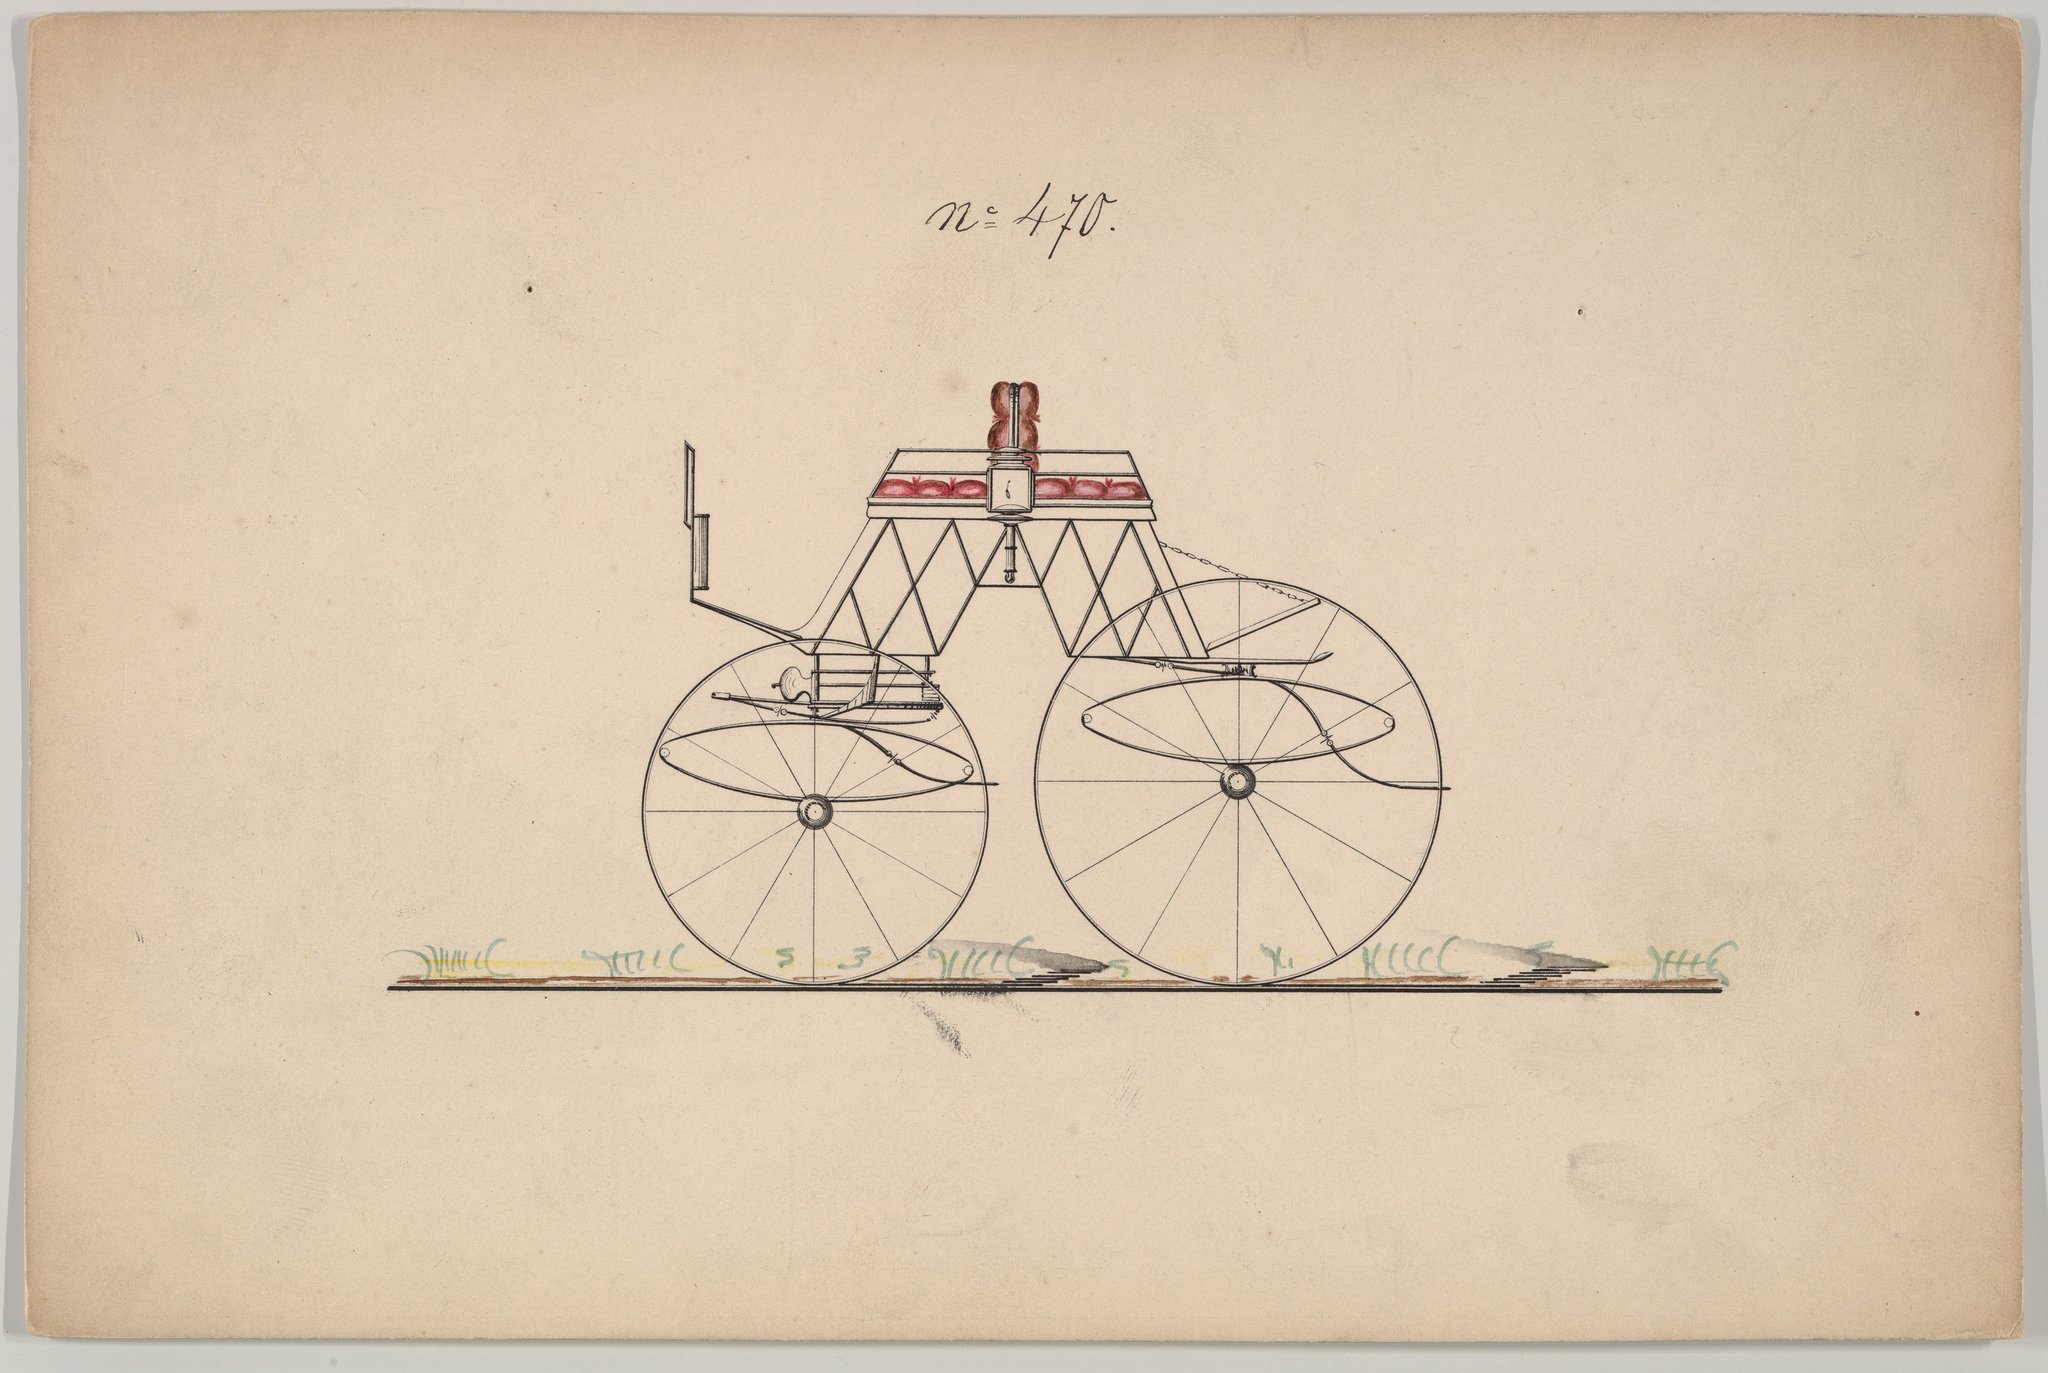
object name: drawing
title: Dog Cart (Phaeton) #470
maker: brewster & co.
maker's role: manufacturer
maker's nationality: american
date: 1850-1870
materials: ink, watercolor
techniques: pen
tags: carriages